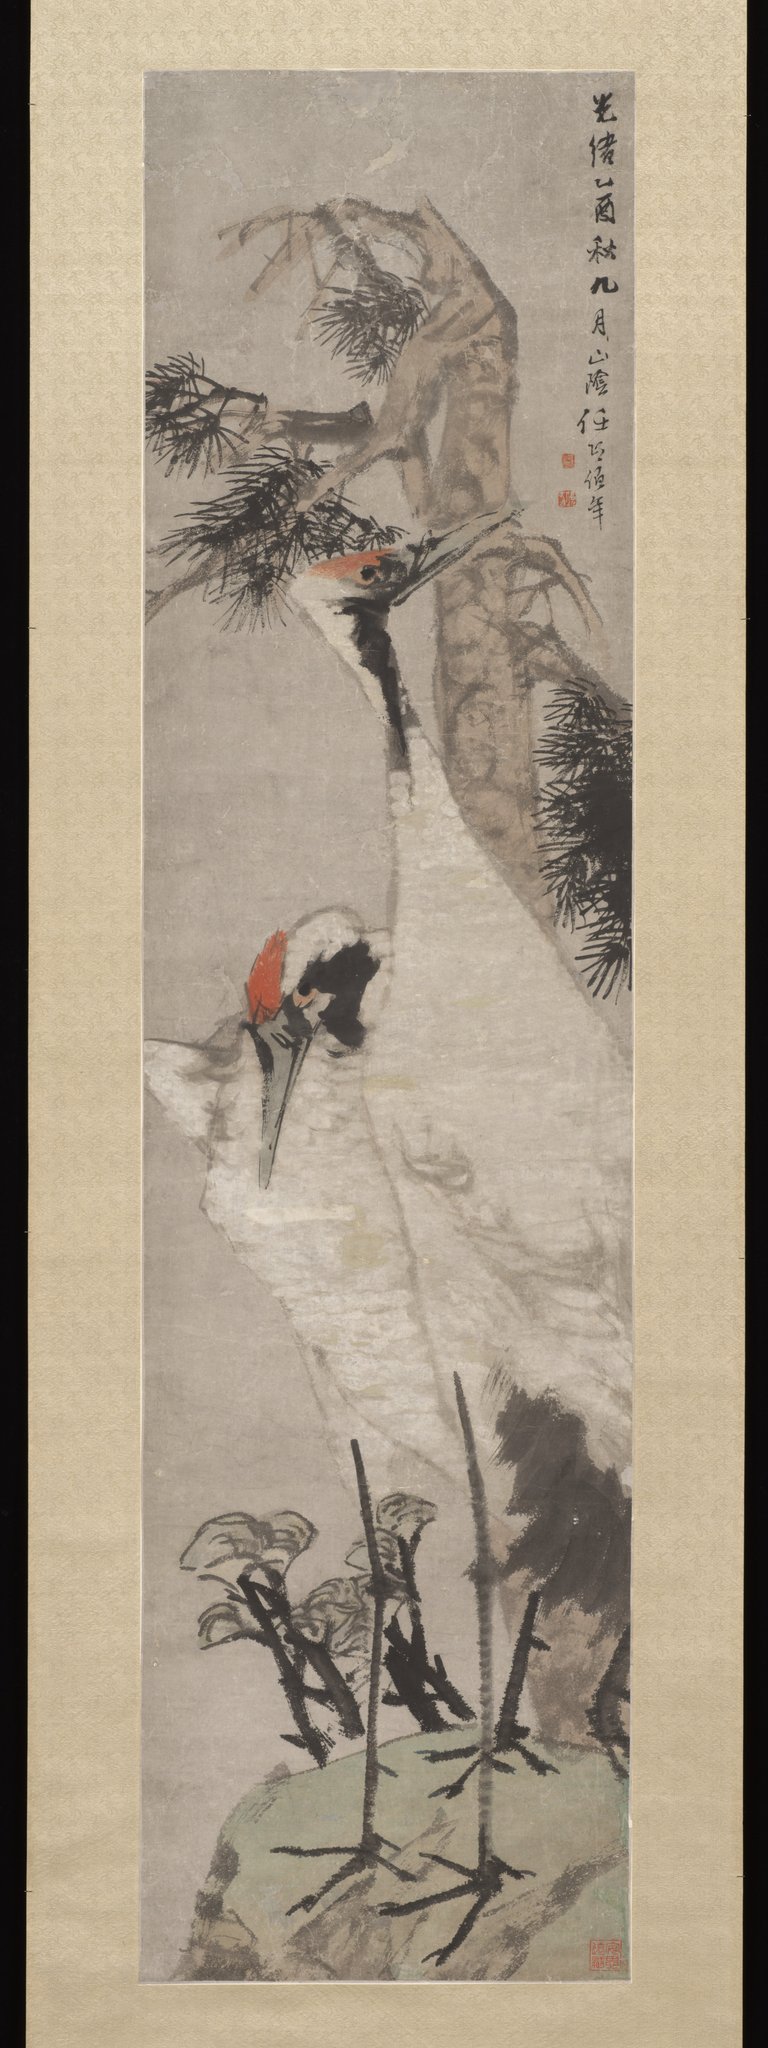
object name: hanging scroll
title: Cranes, Pine Tree, and Lichen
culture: chinese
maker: ren yi (ren bonian)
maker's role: artist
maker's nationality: chinese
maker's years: 1840-1896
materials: ink, paper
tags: cranes